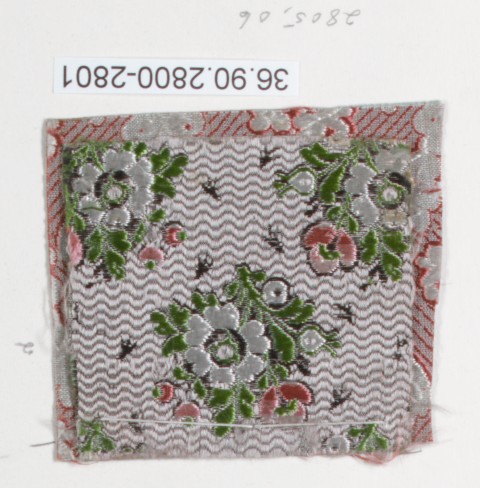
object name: piece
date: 1801-1900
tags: flowers,leaves